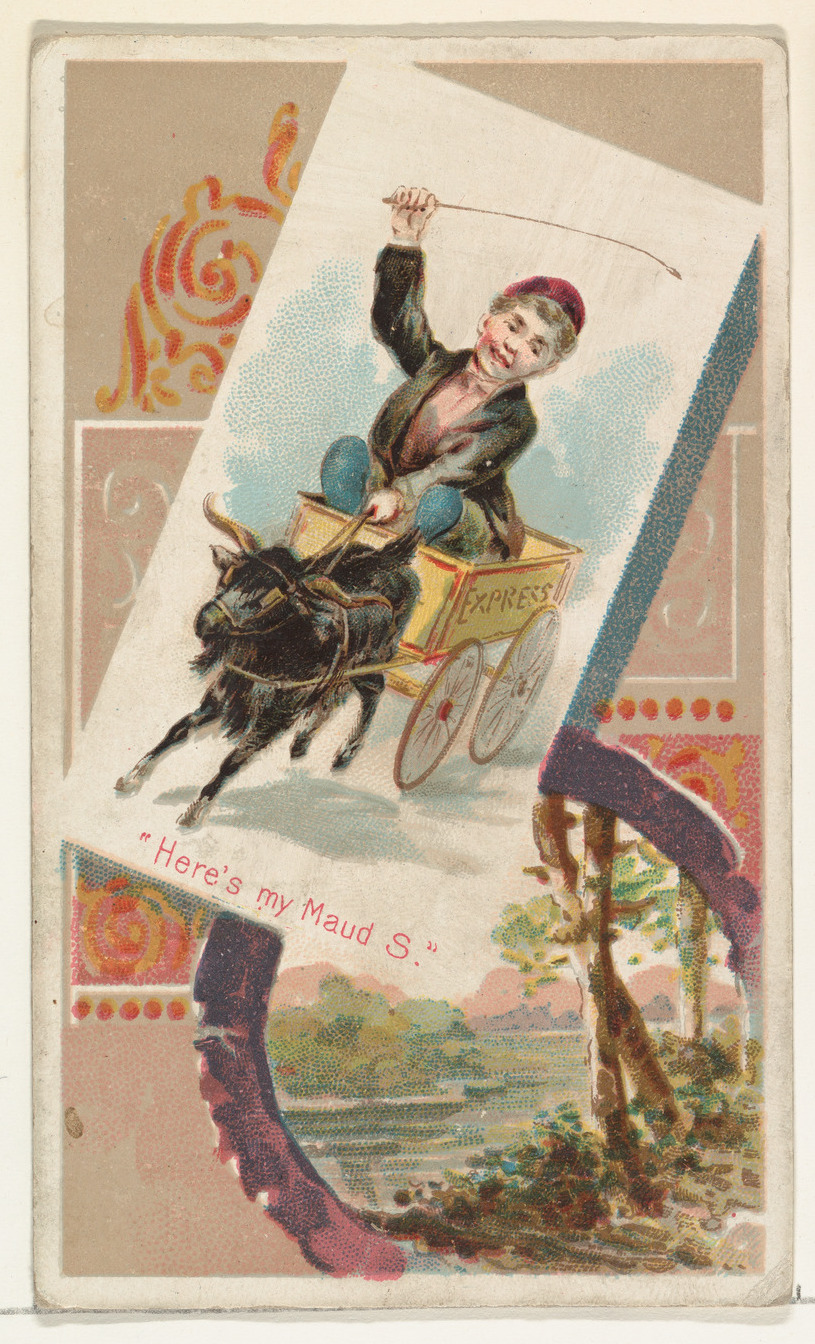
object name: print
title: "Here's my Maud S.," from the Terrors of America set (N136) issued by Duke Sons & Co. to promote Honest Long Cut Tobacco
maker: w. duke, sons & co.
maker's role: publisher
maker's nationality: american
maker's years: 1870-1920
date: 1888-1889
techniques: color lithograph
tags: animals,boys,wagons